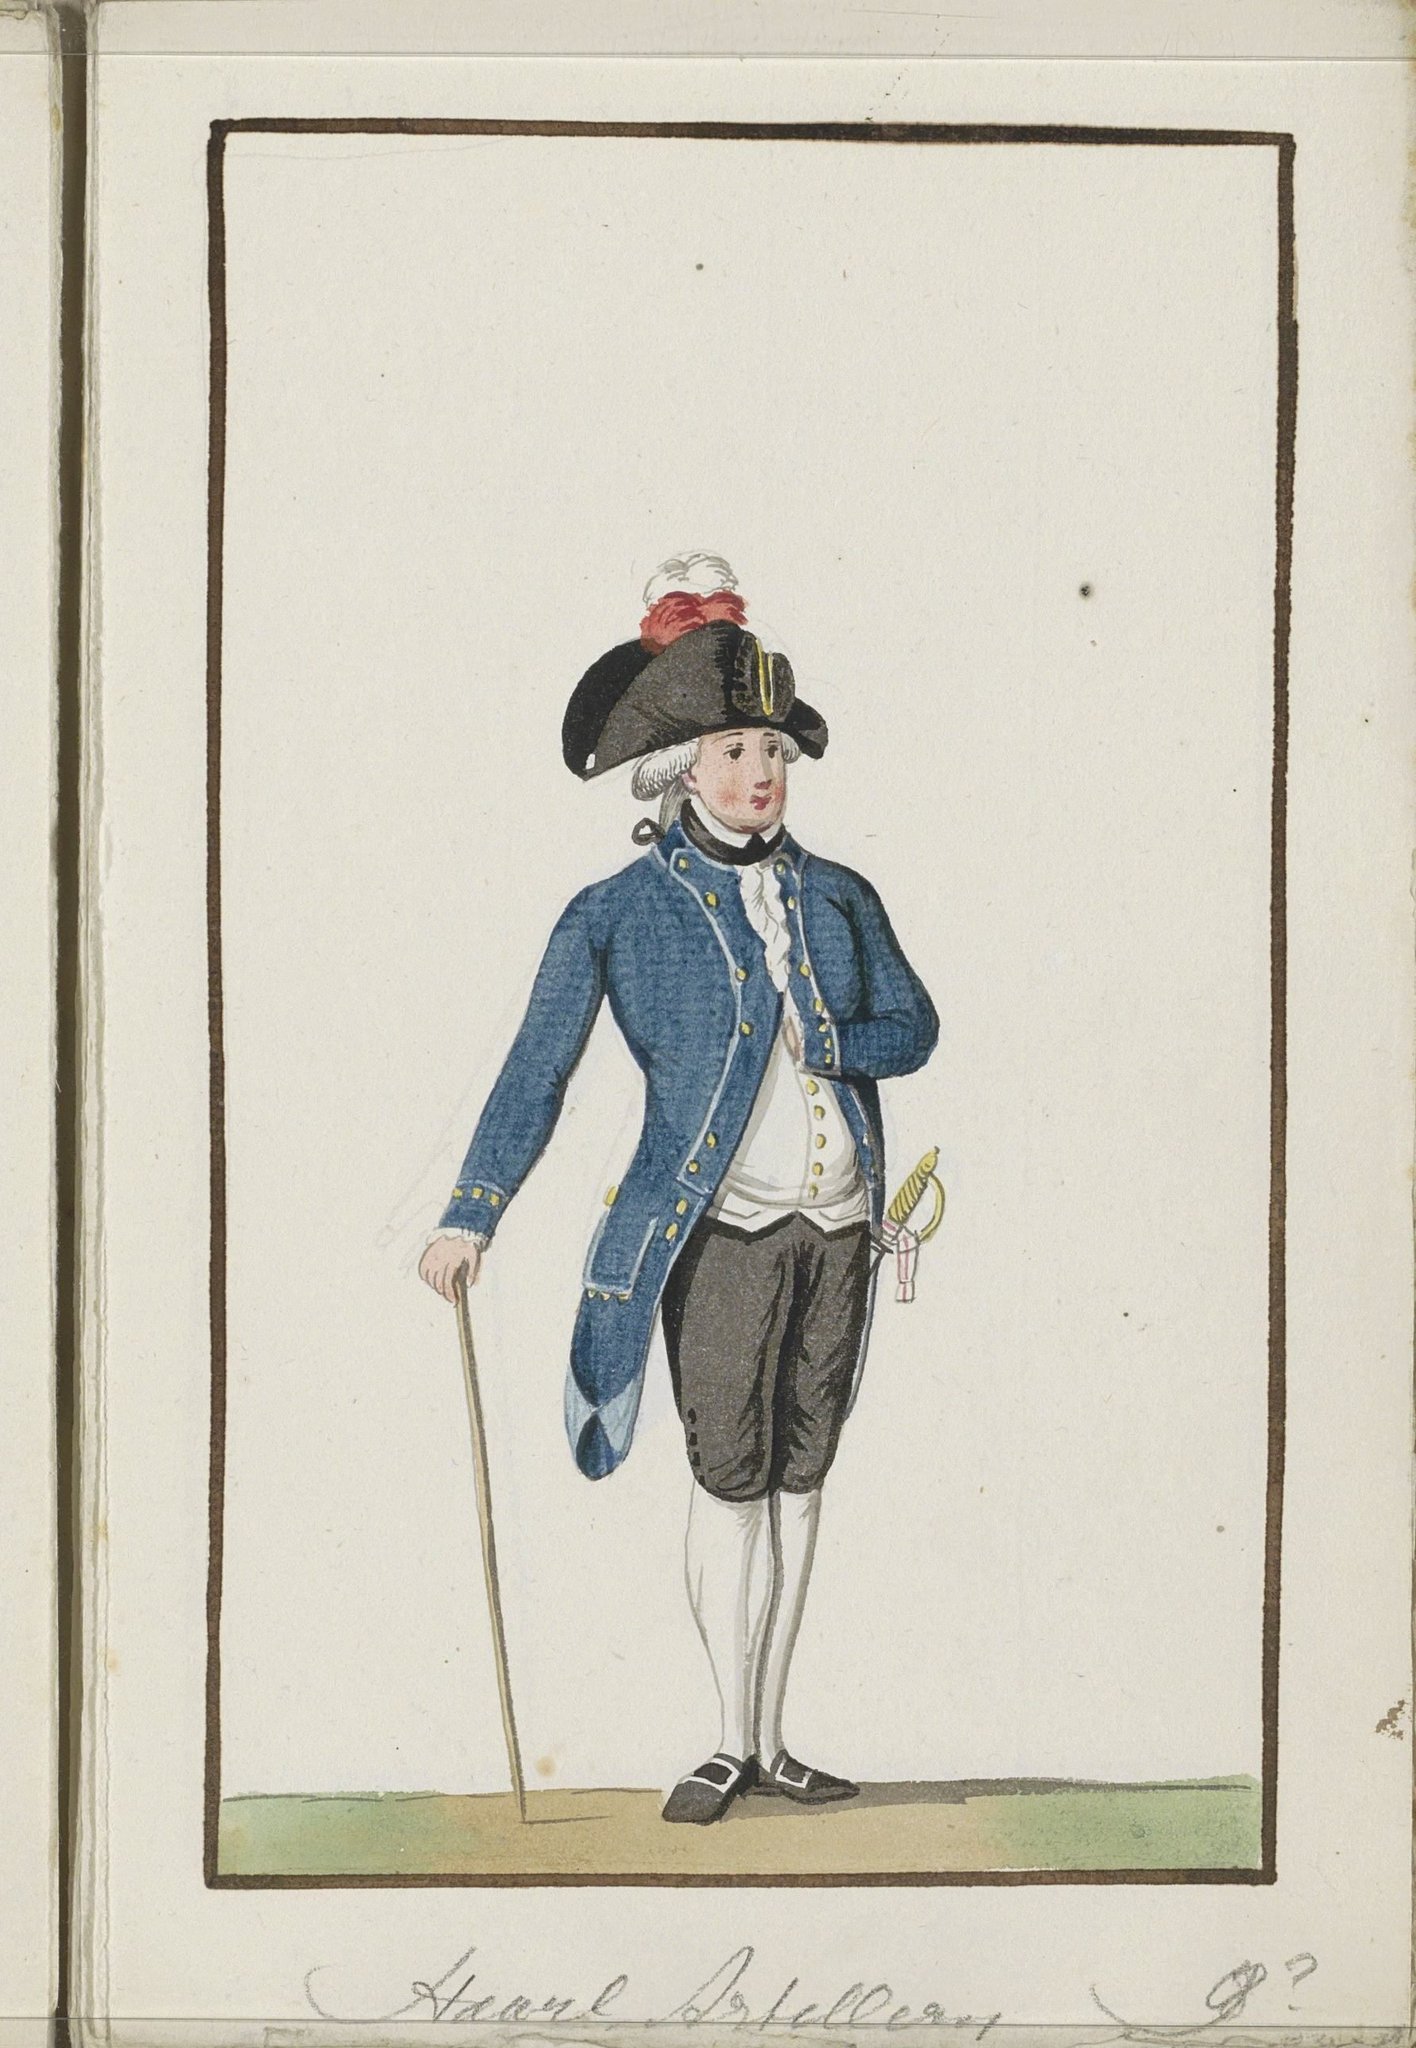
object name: drawing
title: Haarlem Atlary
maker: Anonymous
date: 1789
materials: paper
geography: northern netherlands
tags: (military) uniforms (+ citizen soldiery, civil guard, citizen militia), haarlem, patriots (1780-1795)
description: Montering of uniform van de Haarlemse artillerie, ca. 1785. Onderdeel van een schetsboek met 41 gekleurde tekeningen van de monteringen van de gewapende schutterijen en burgercorpsen in Nederland in de periode ca. 1783-1789.